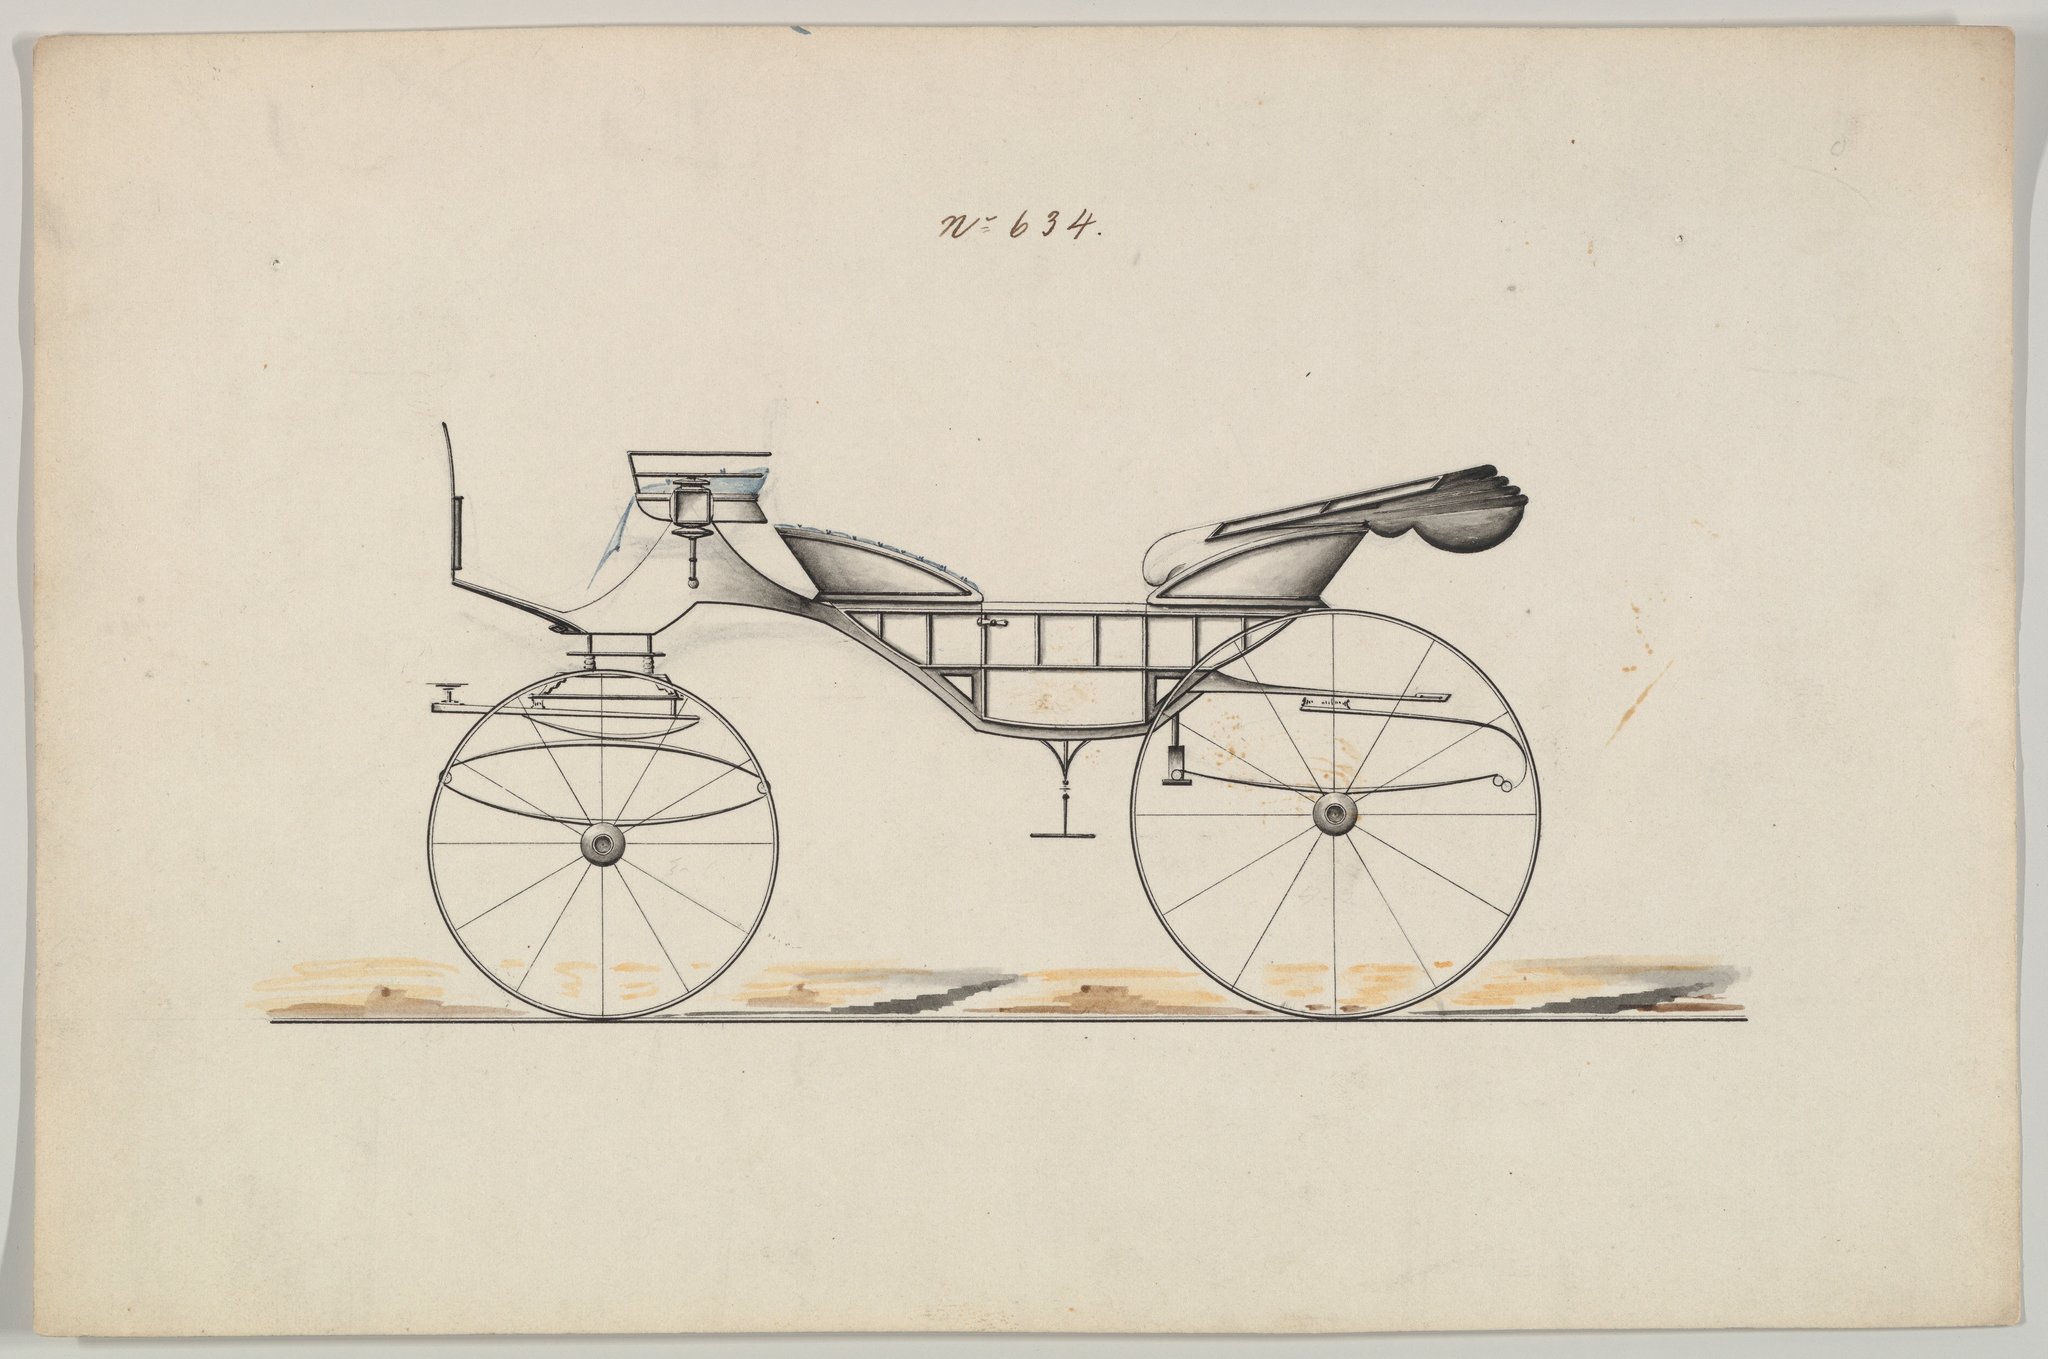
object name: drawing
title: Design for Vis-à-vis, no. 634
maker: brewster & co.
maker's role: manufacturer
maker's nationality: american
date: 1850-1870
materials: ink, watercolor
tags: carriages